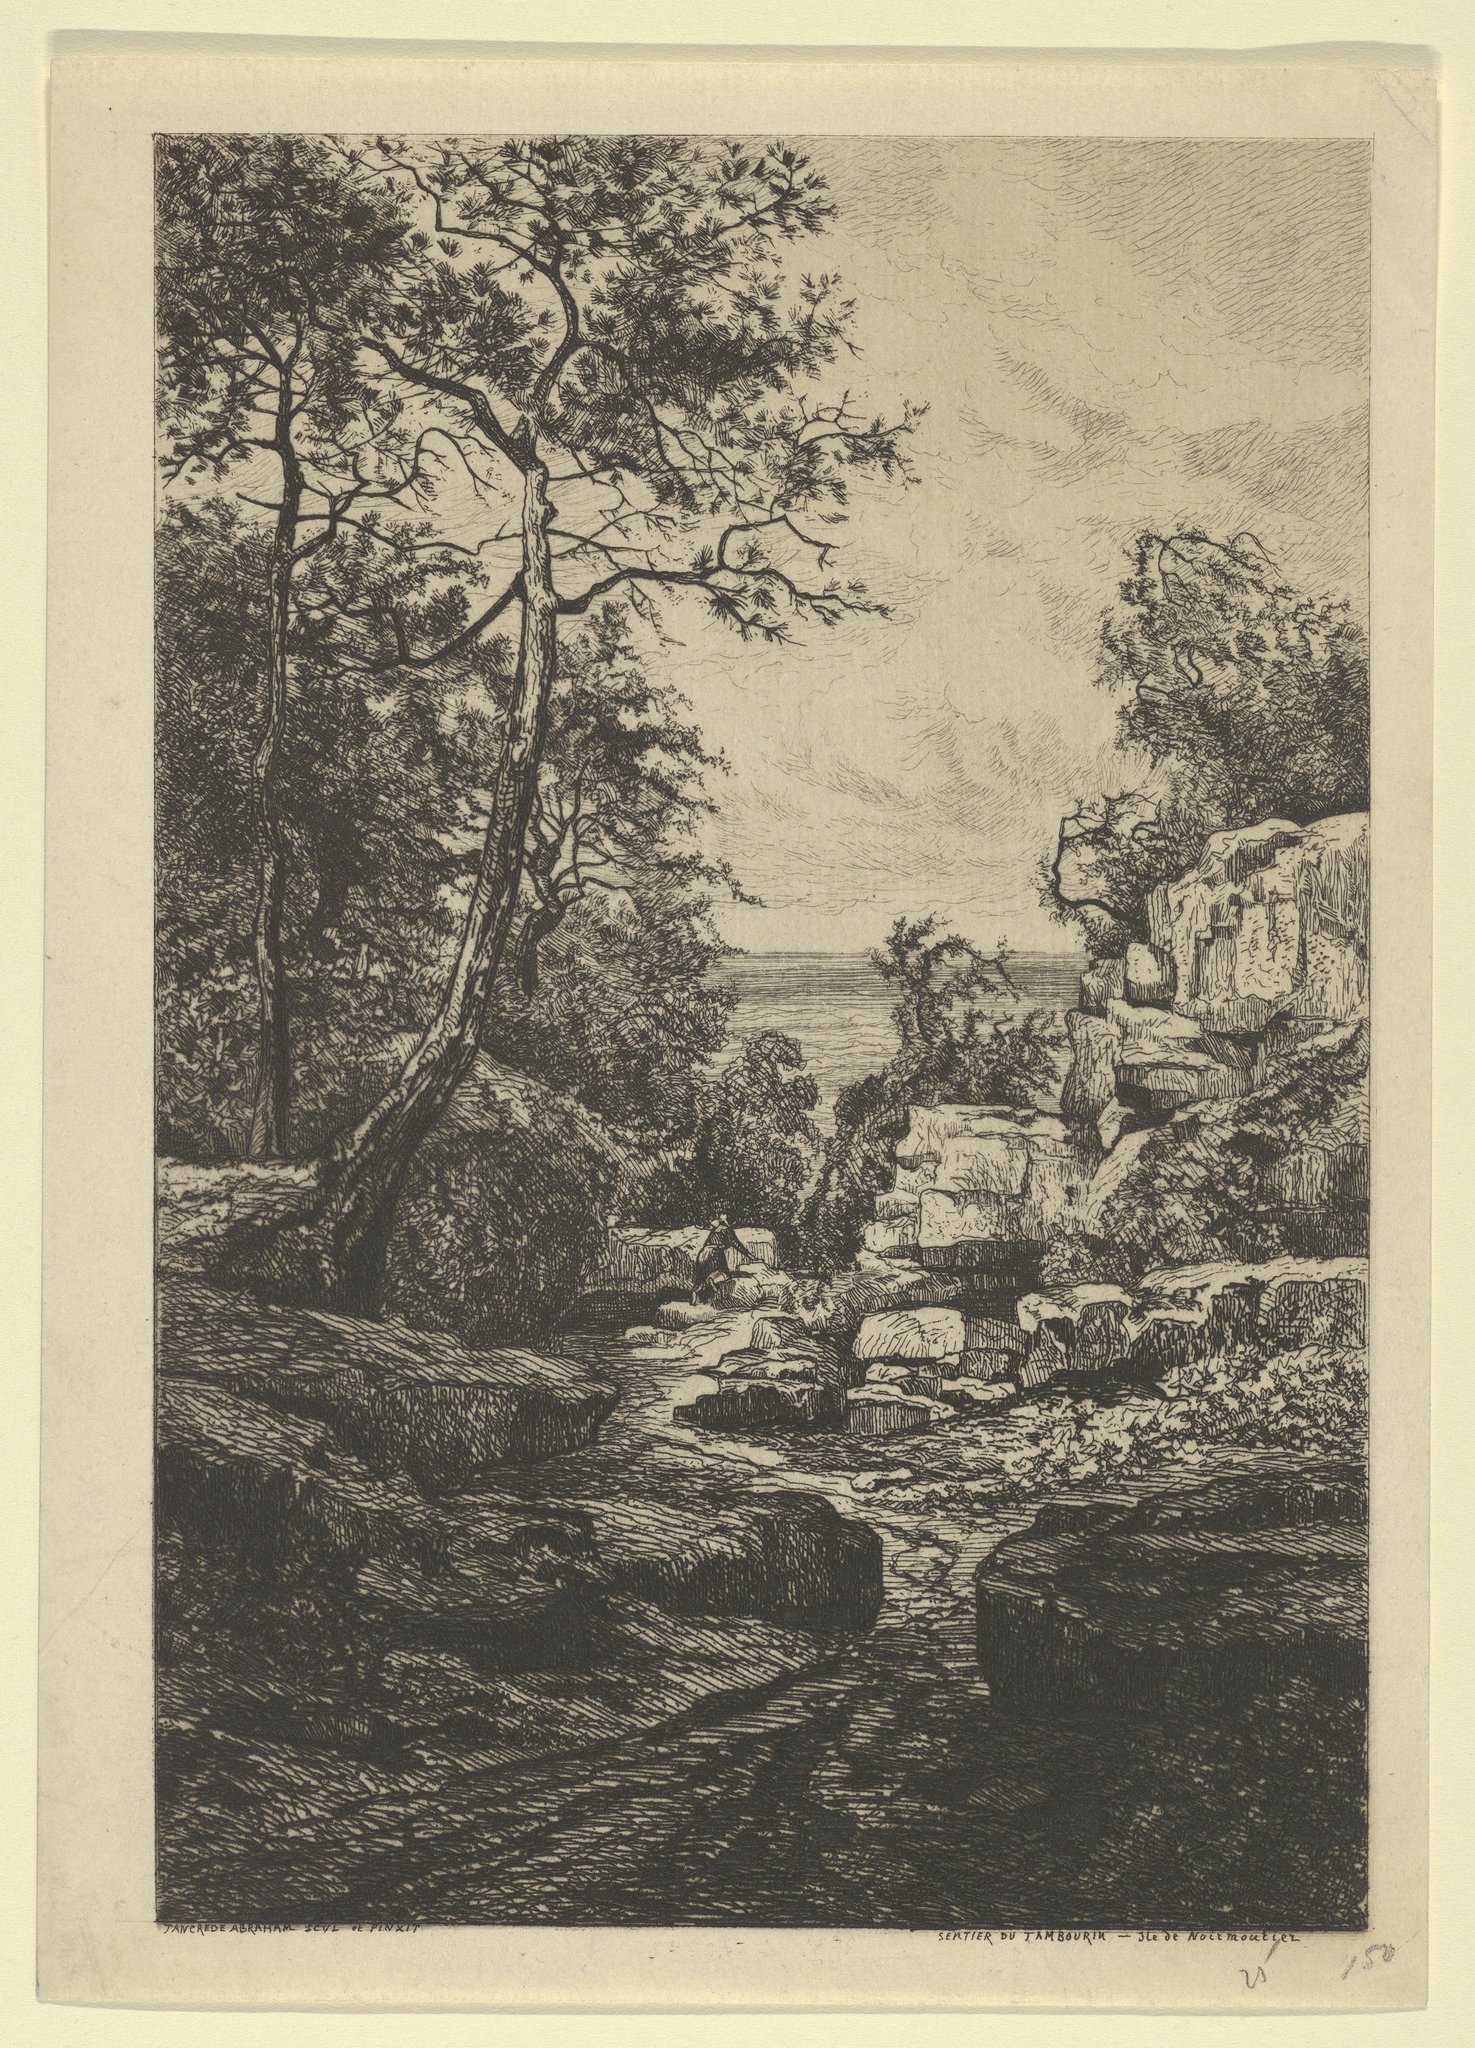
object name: print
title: Sentier du Tambourin, Ile de Noirmoutier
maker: tancrède abraham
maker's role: artist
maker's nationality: french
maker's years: 1836-1895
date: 1801-1900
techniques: etching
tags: landscapes,trees